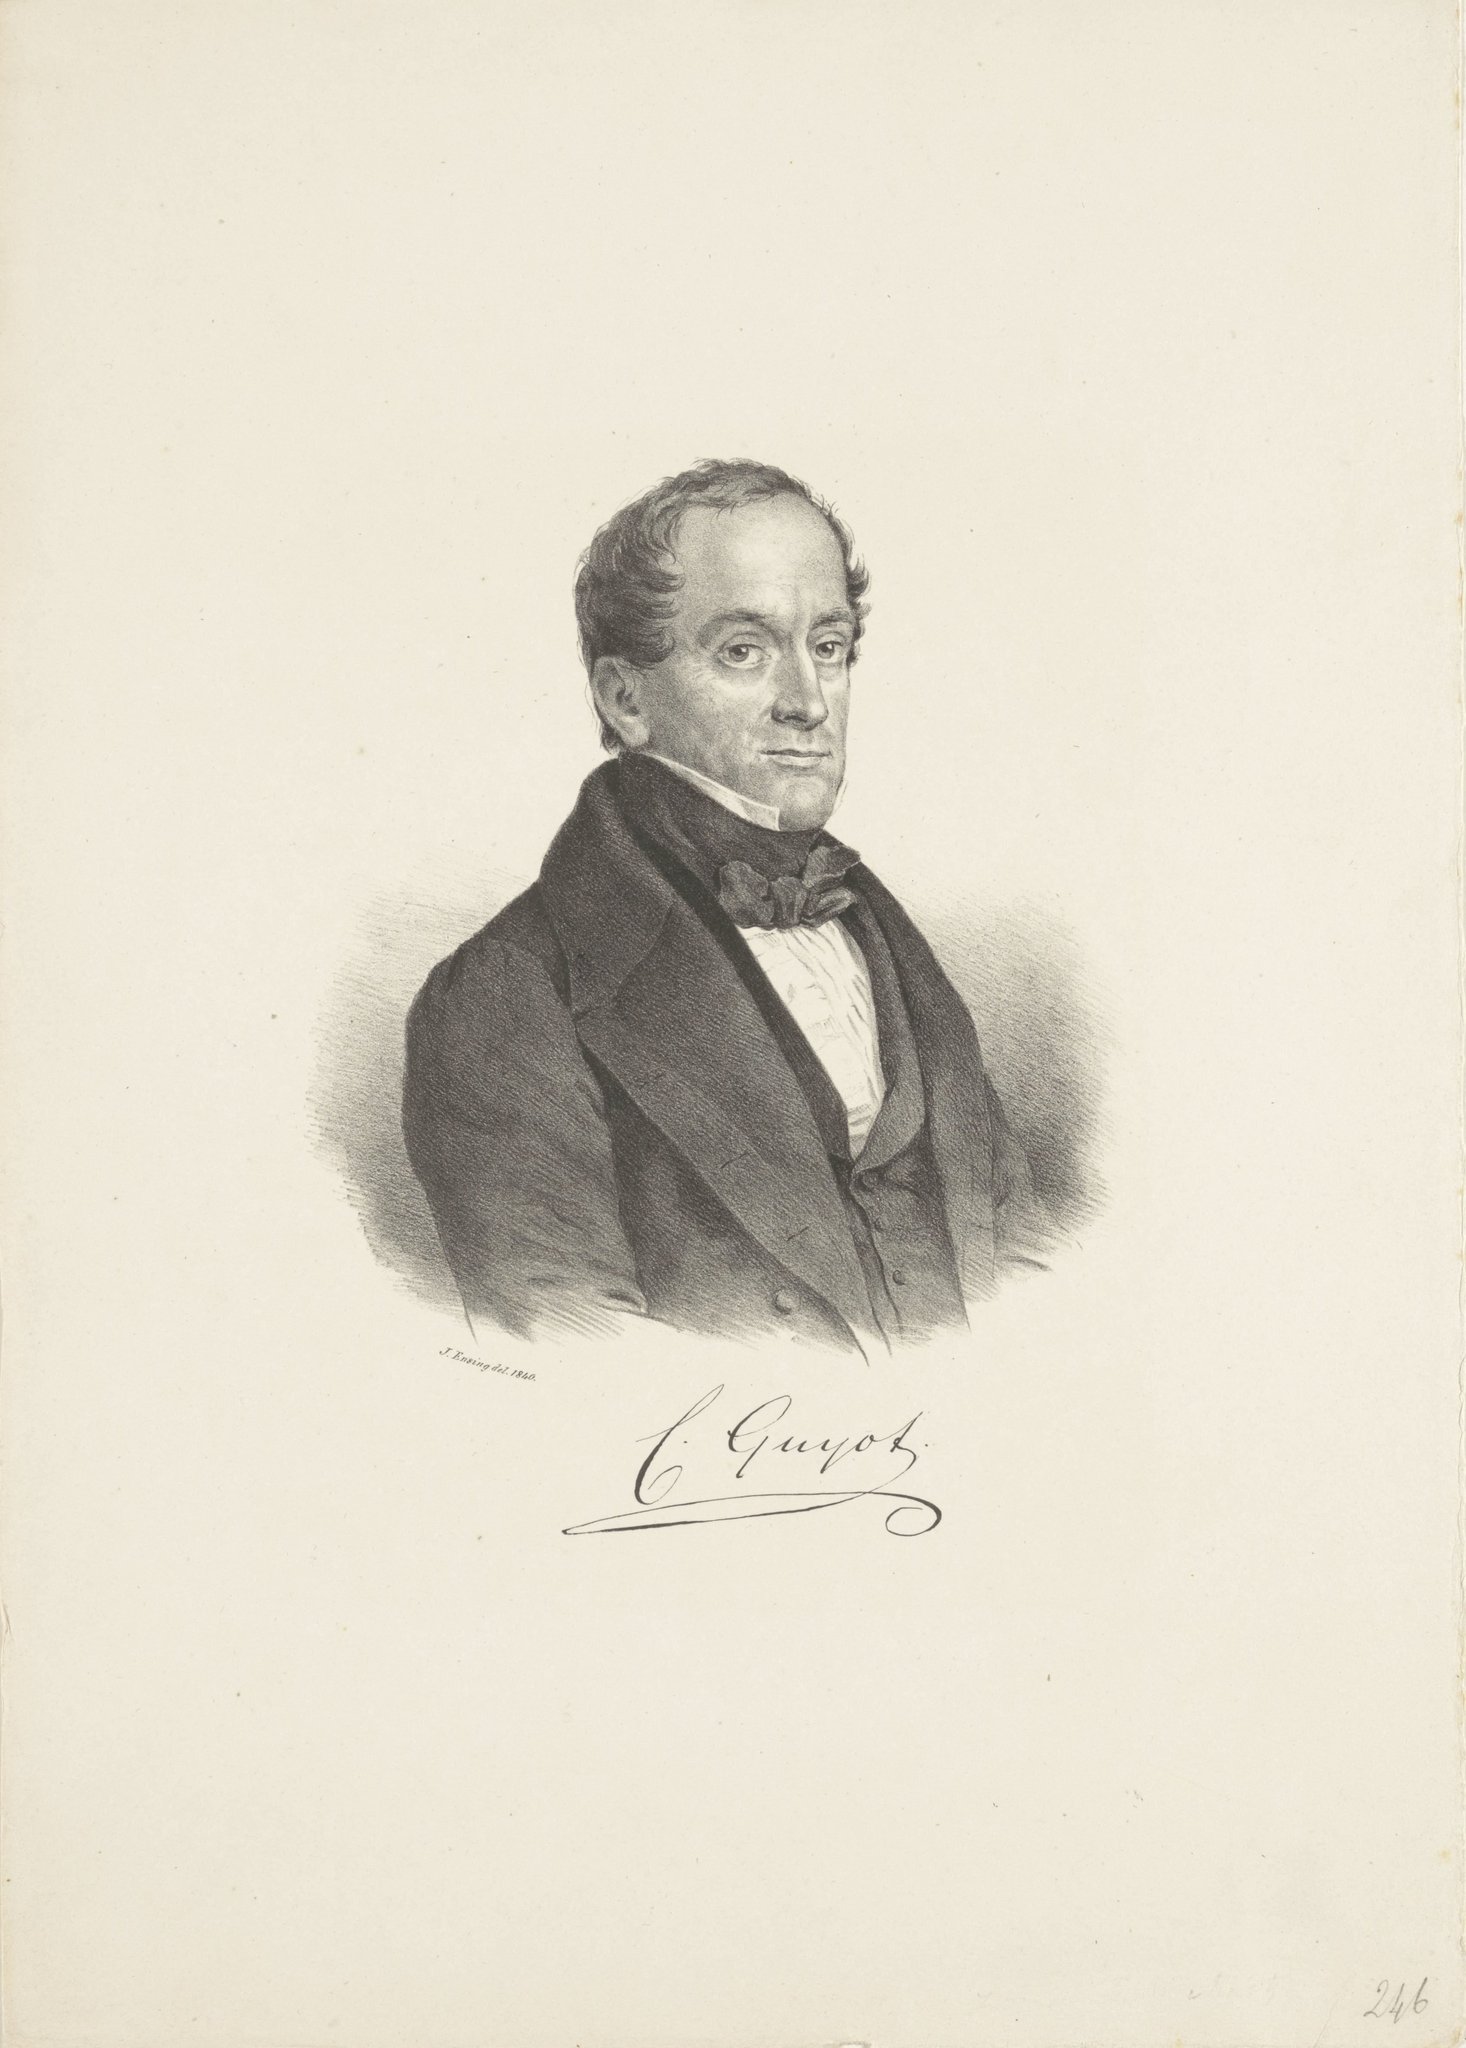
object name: print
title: Portret van C. Guyot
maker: jan ensing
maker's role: draughtsman, painter, print maker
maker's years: 1819-1894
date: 1840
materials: paper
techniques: lithograph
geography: groningen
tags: historical persons (+ (full) bust portrait)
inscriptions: collector's mark: Lugt 2228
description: De geportretteerde zit naar rechts gewend. Onder het portret zijn signatuur.